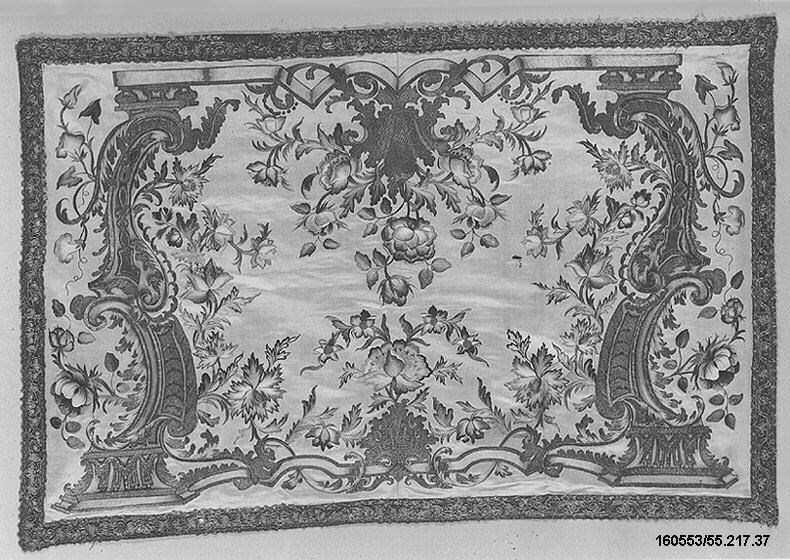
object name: panel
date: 1734-1766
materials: metal thread, silk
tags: flowers